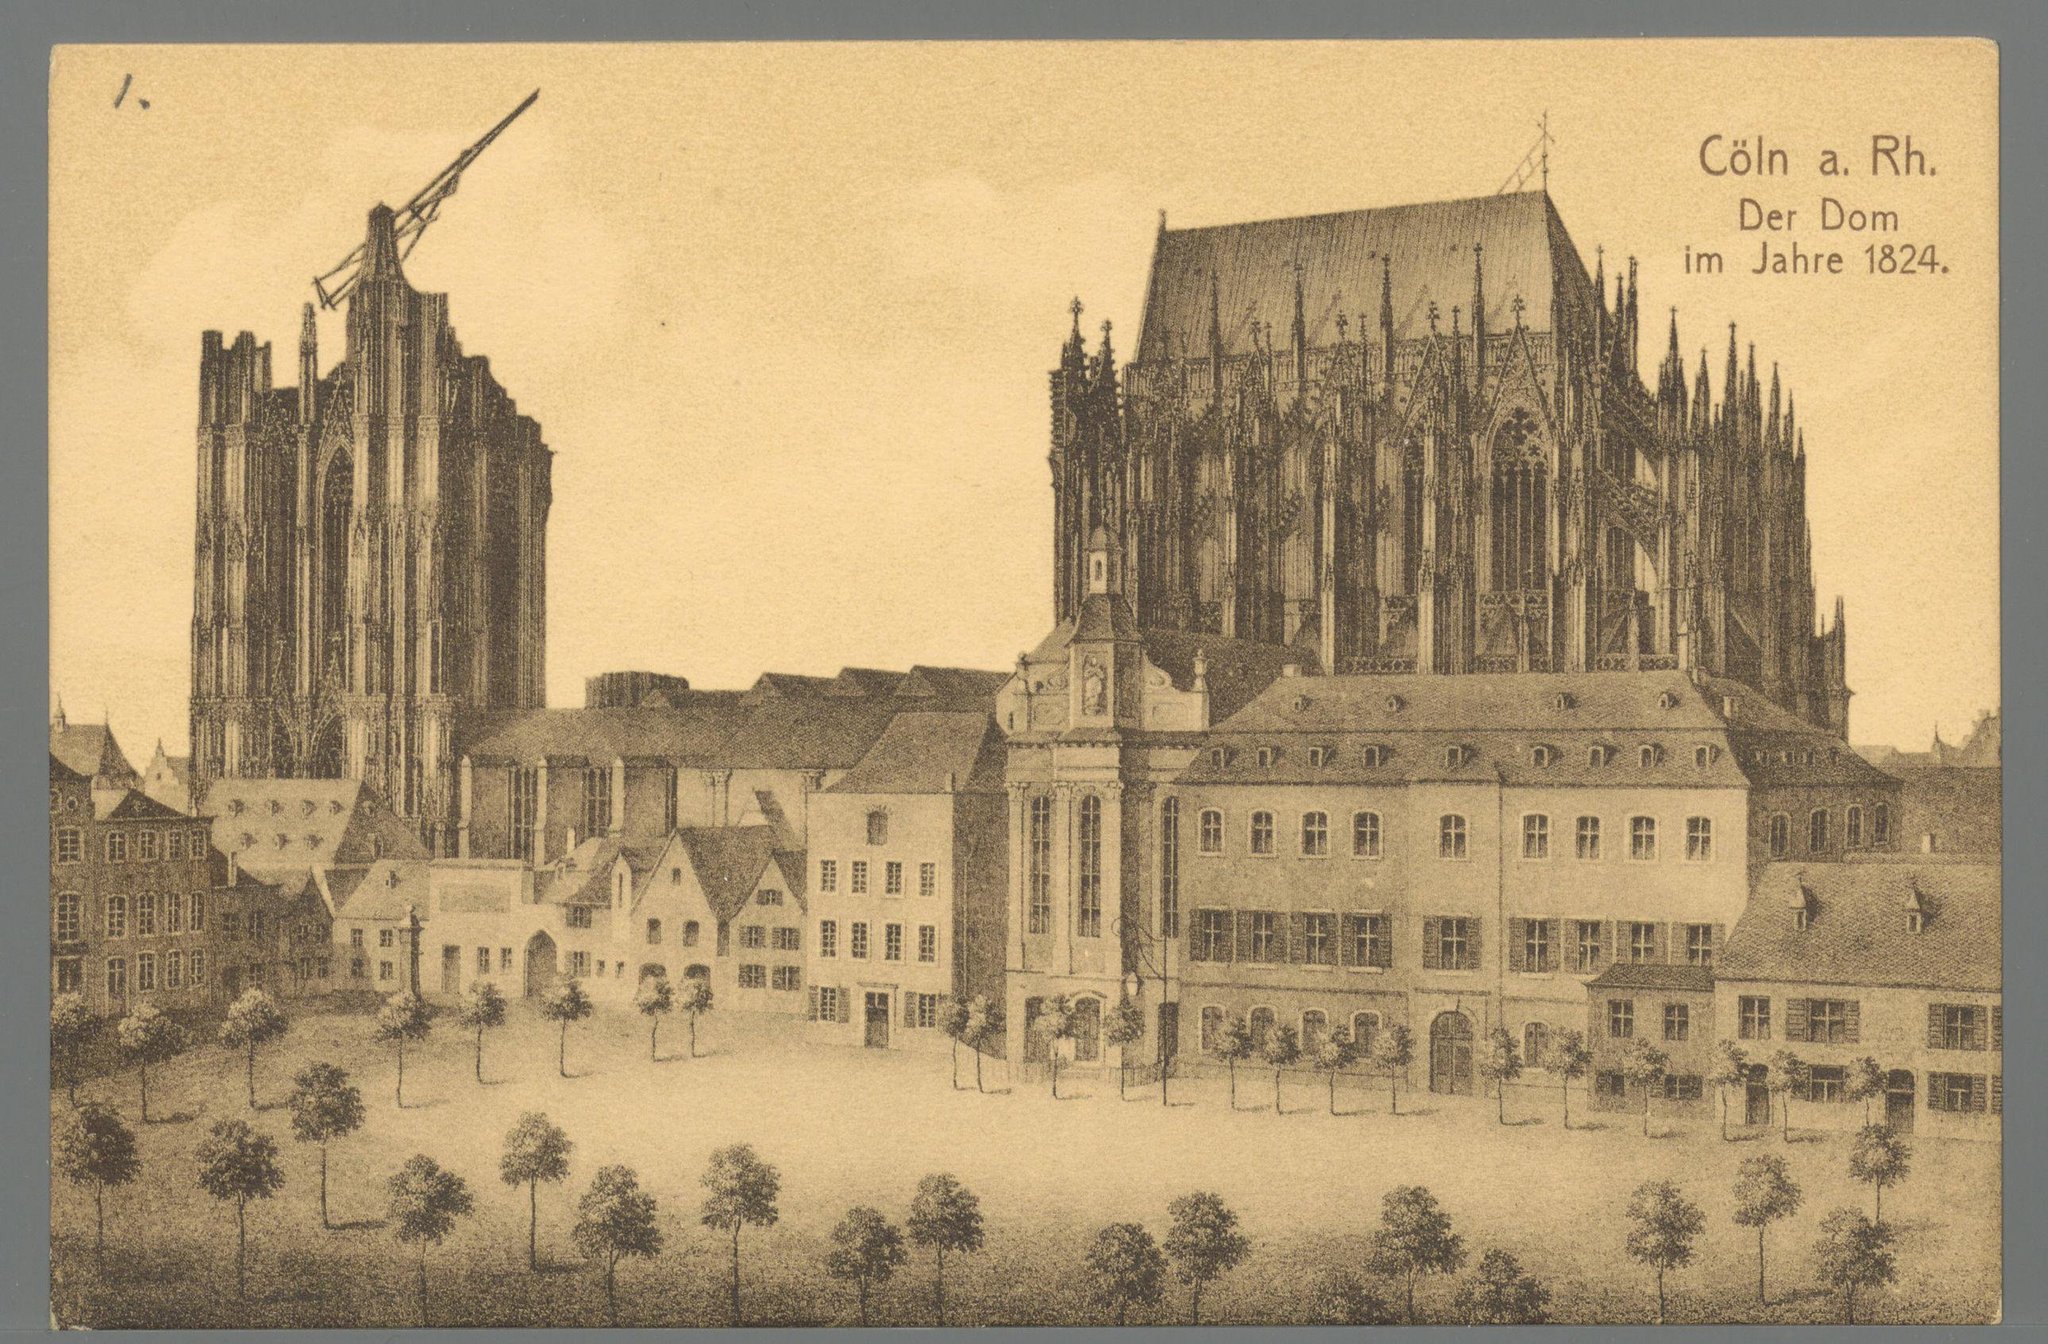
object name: photomechanical print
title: Cöln a. Rh. Der Dom im Jahre 1824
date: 1905-1930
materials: cardboard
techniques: photograph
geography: cologne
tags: square, place, circus, etc., church (exterior)